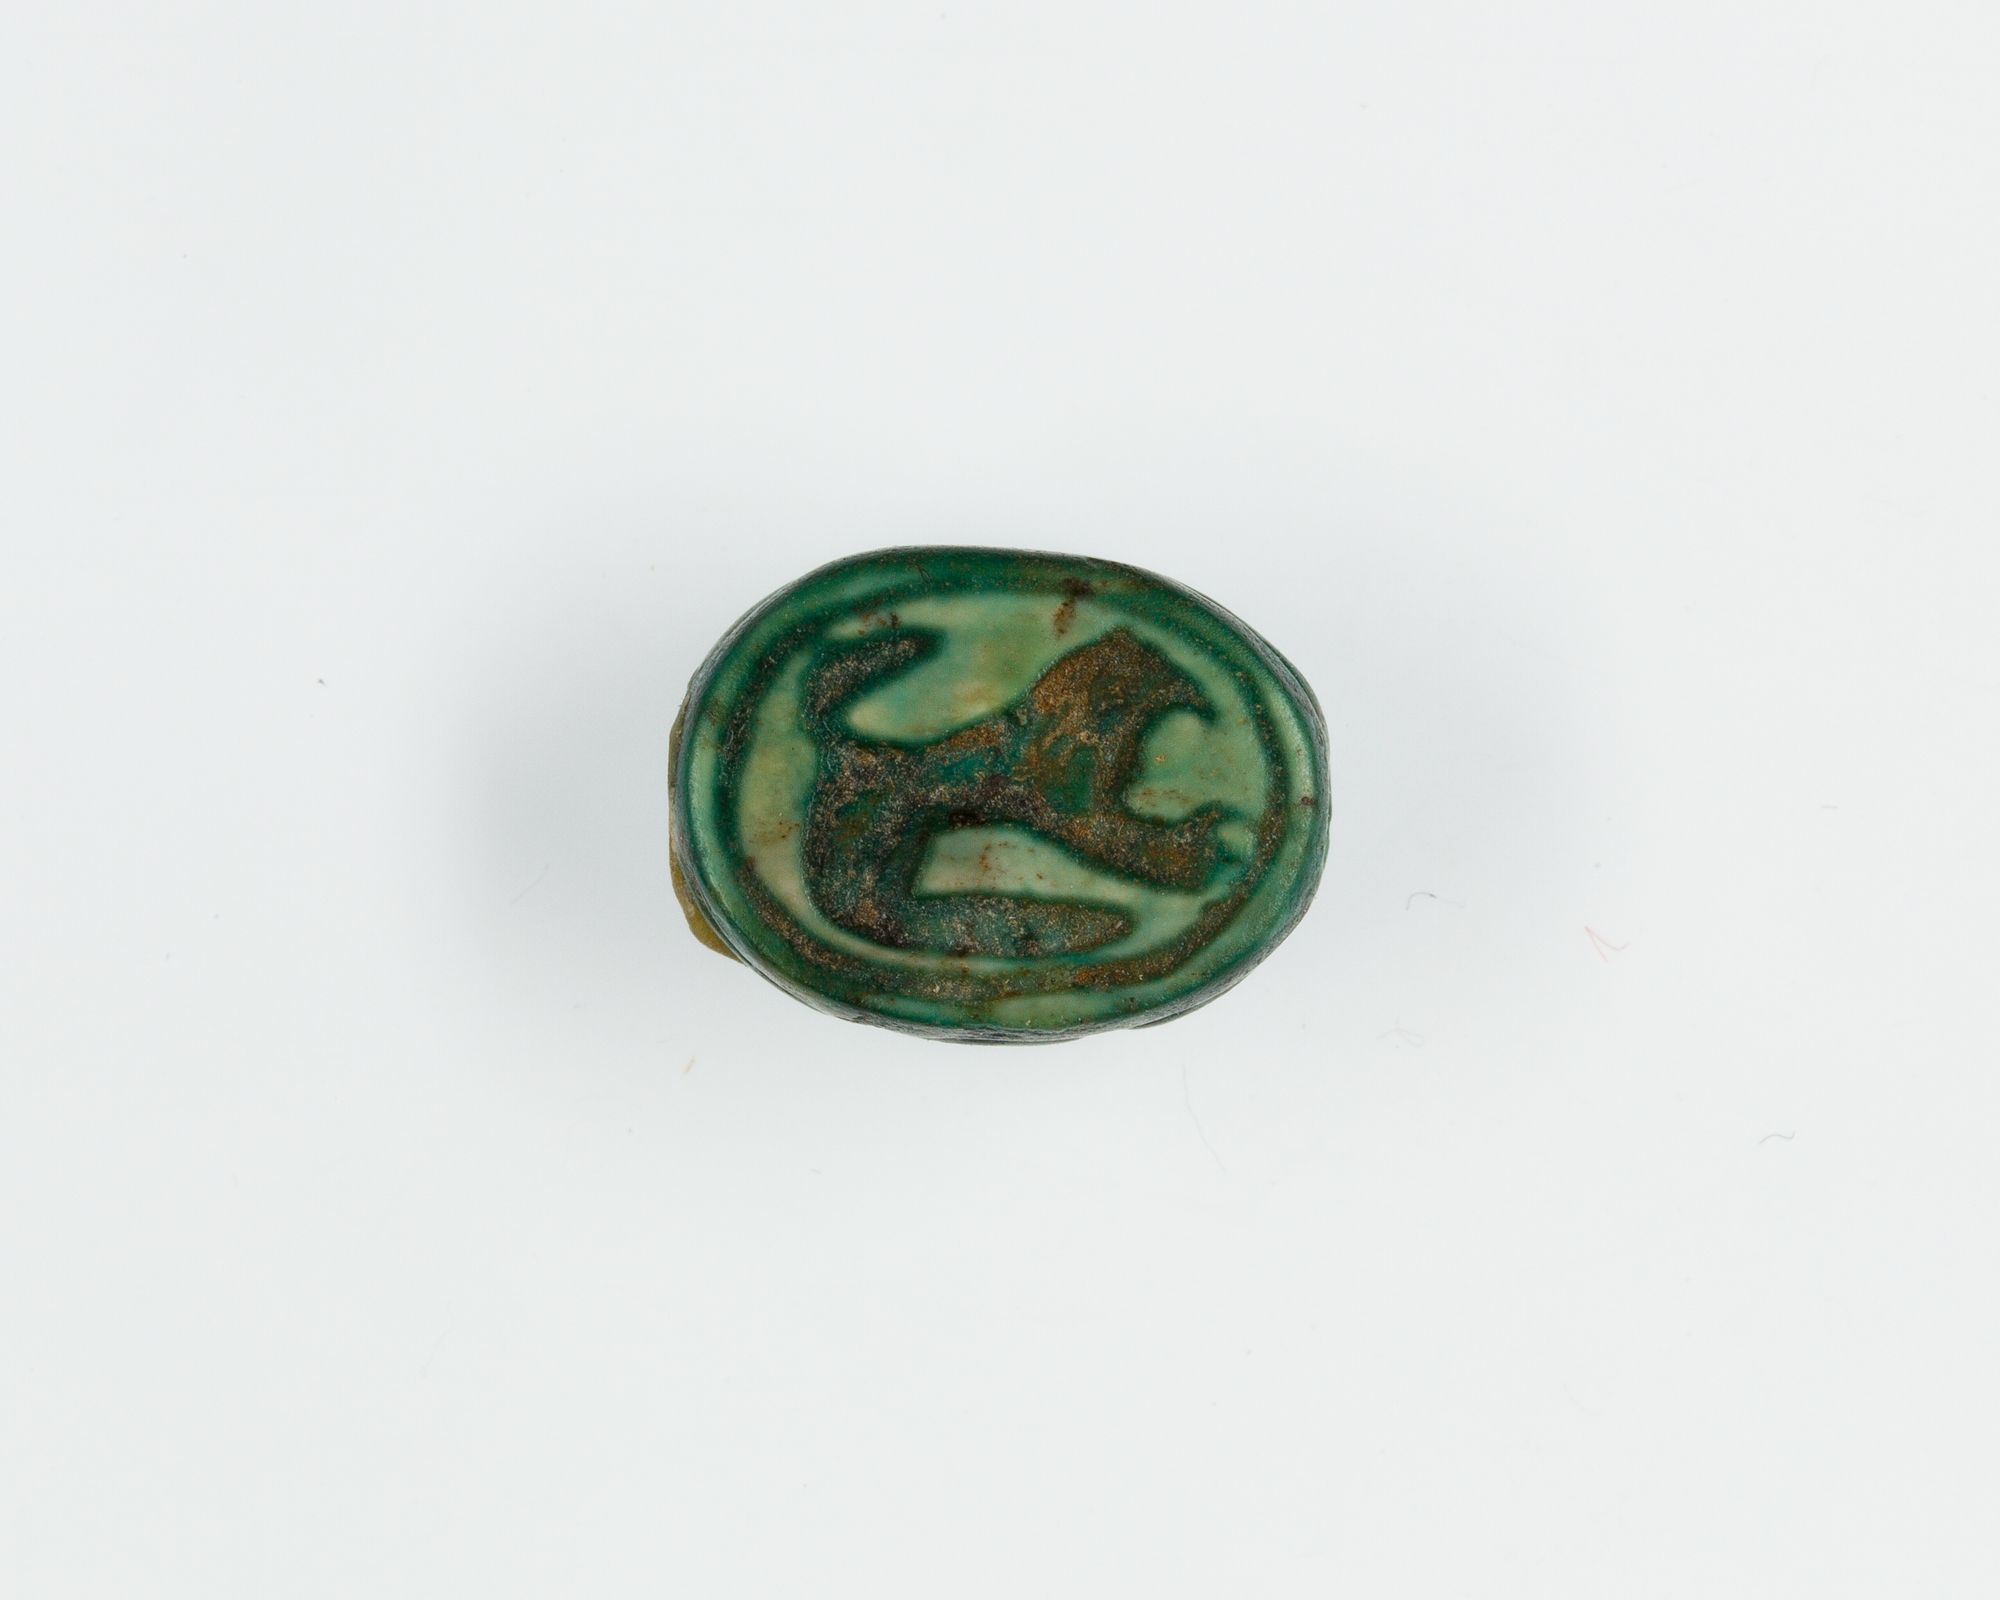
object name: scarab, griffin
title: Scarab depicting a griffin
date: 1786-1482 BCE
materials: faience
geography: egypt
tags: griffins,scarabs